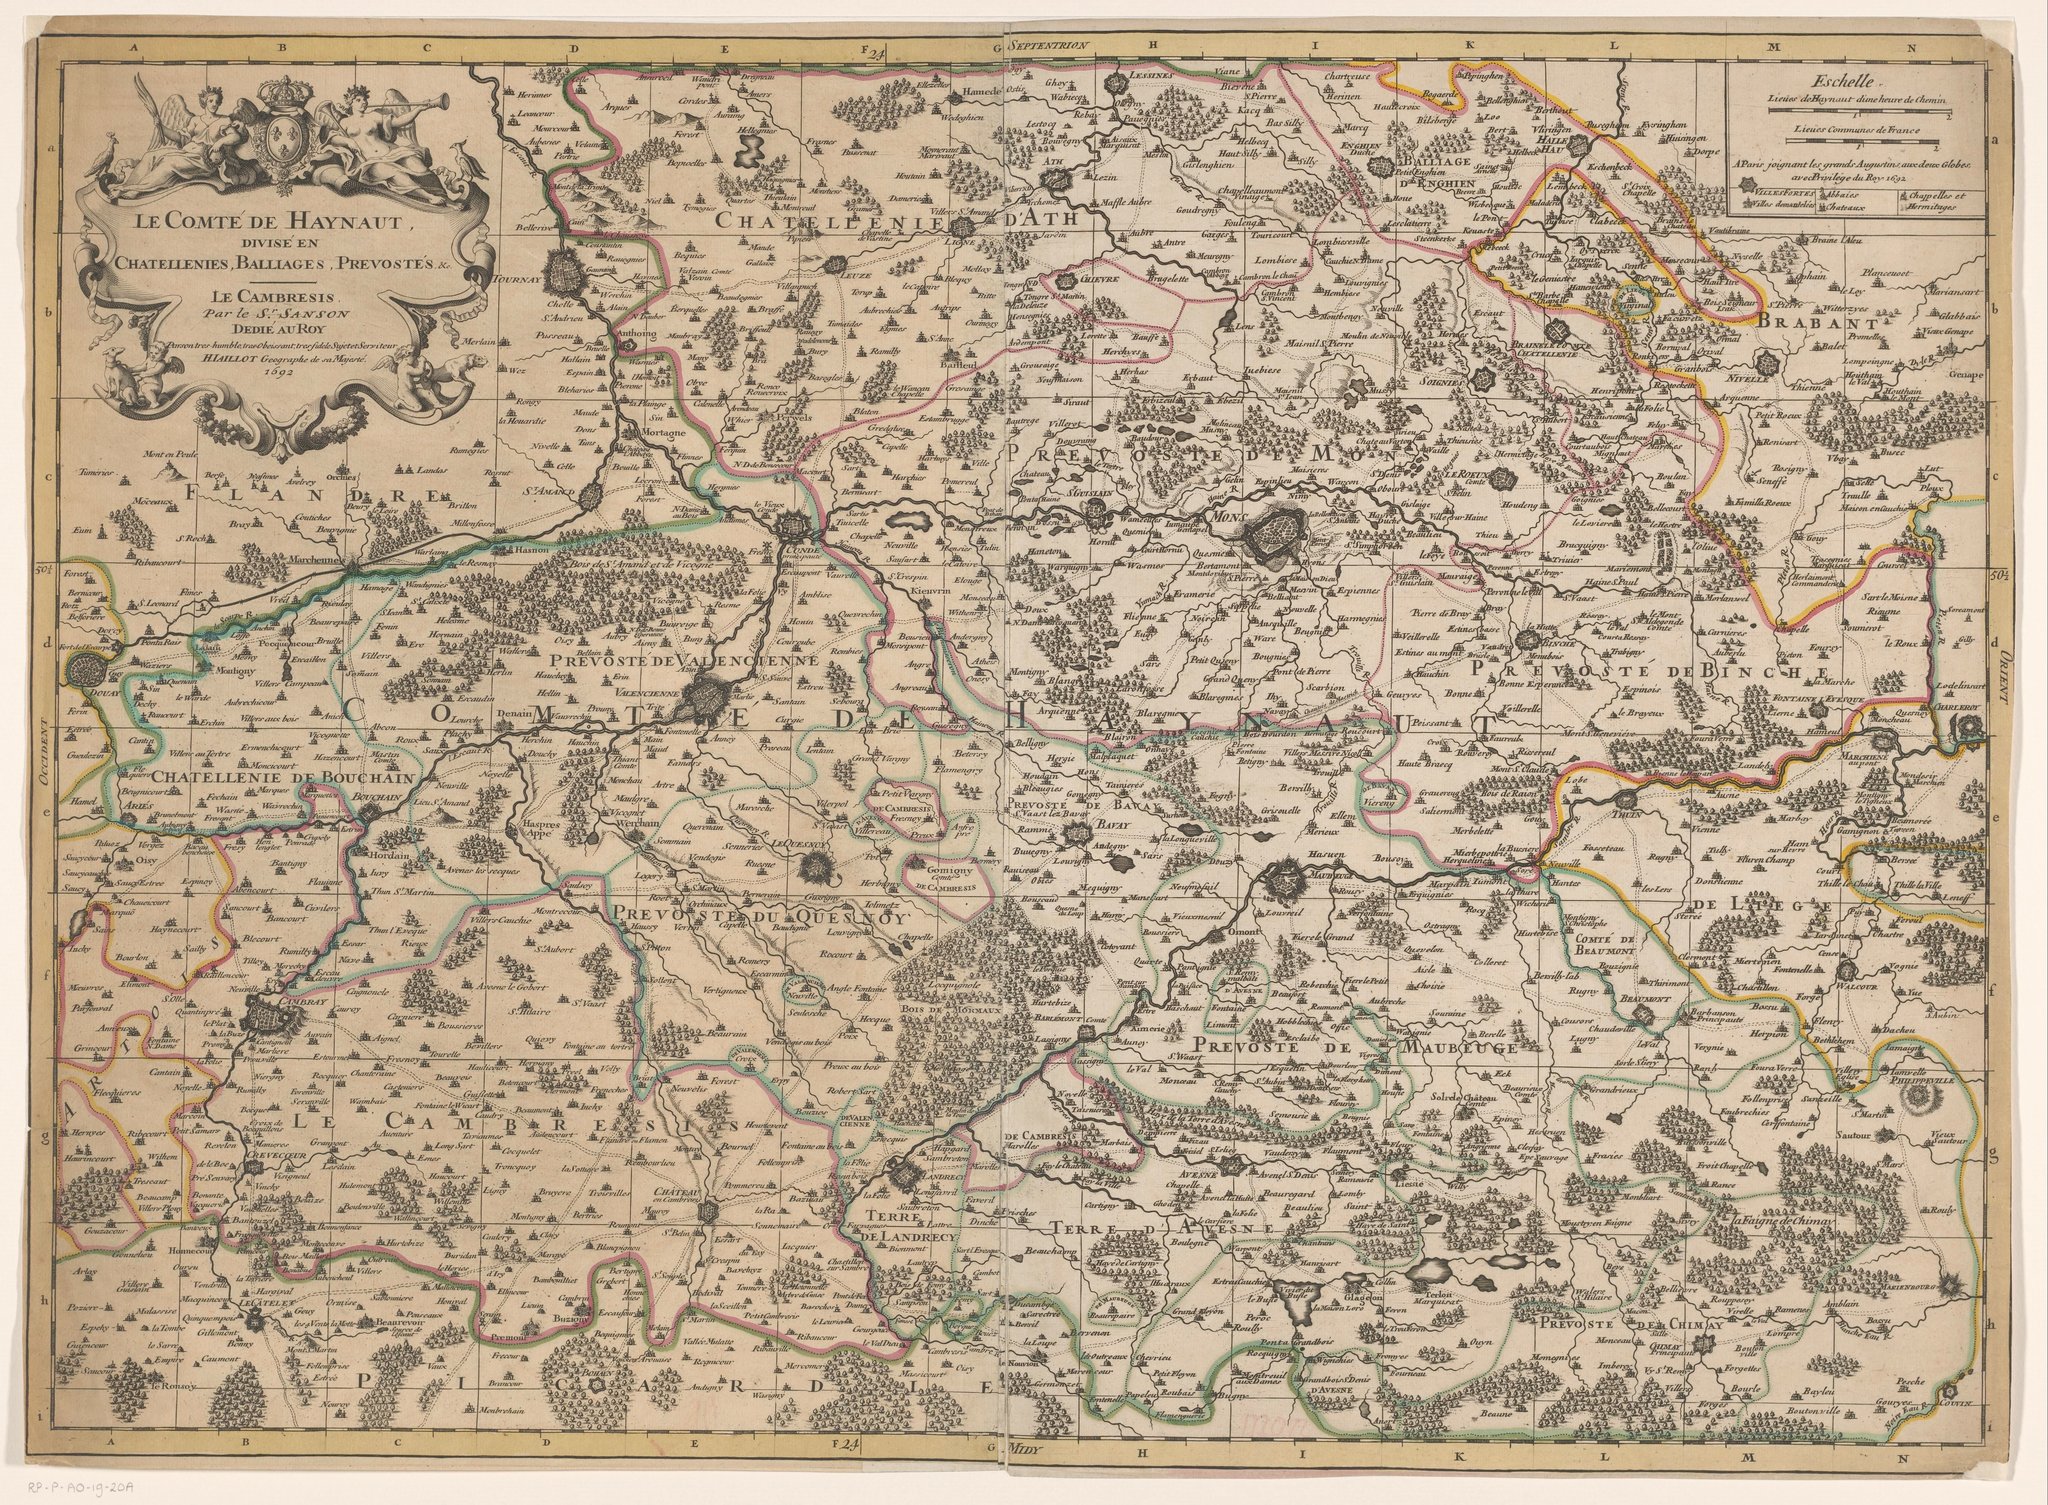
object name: print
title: Le comté de Haynaut divisé en Chateillenies, Balliages, Prevoste & c.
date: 1692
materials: paper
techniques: engraving, etching, hand coloring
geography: paris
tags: maps of separate countries or regions, henegouwen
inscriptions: collector's mark: Lugt 195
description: Kaart van het graafschap Henegouwen. Linksboven de titelcartouche met bovenin het wapen van de koning van Frankrijk. Rechtsboven een kader met twee schaalstokken: Lieües de Haynaut d'une heure de Chemin / Lieües Communes de France. Hieronder een legenda. De kaart is voorzien een zoekrooster en een gradenverdeling langs de randen.